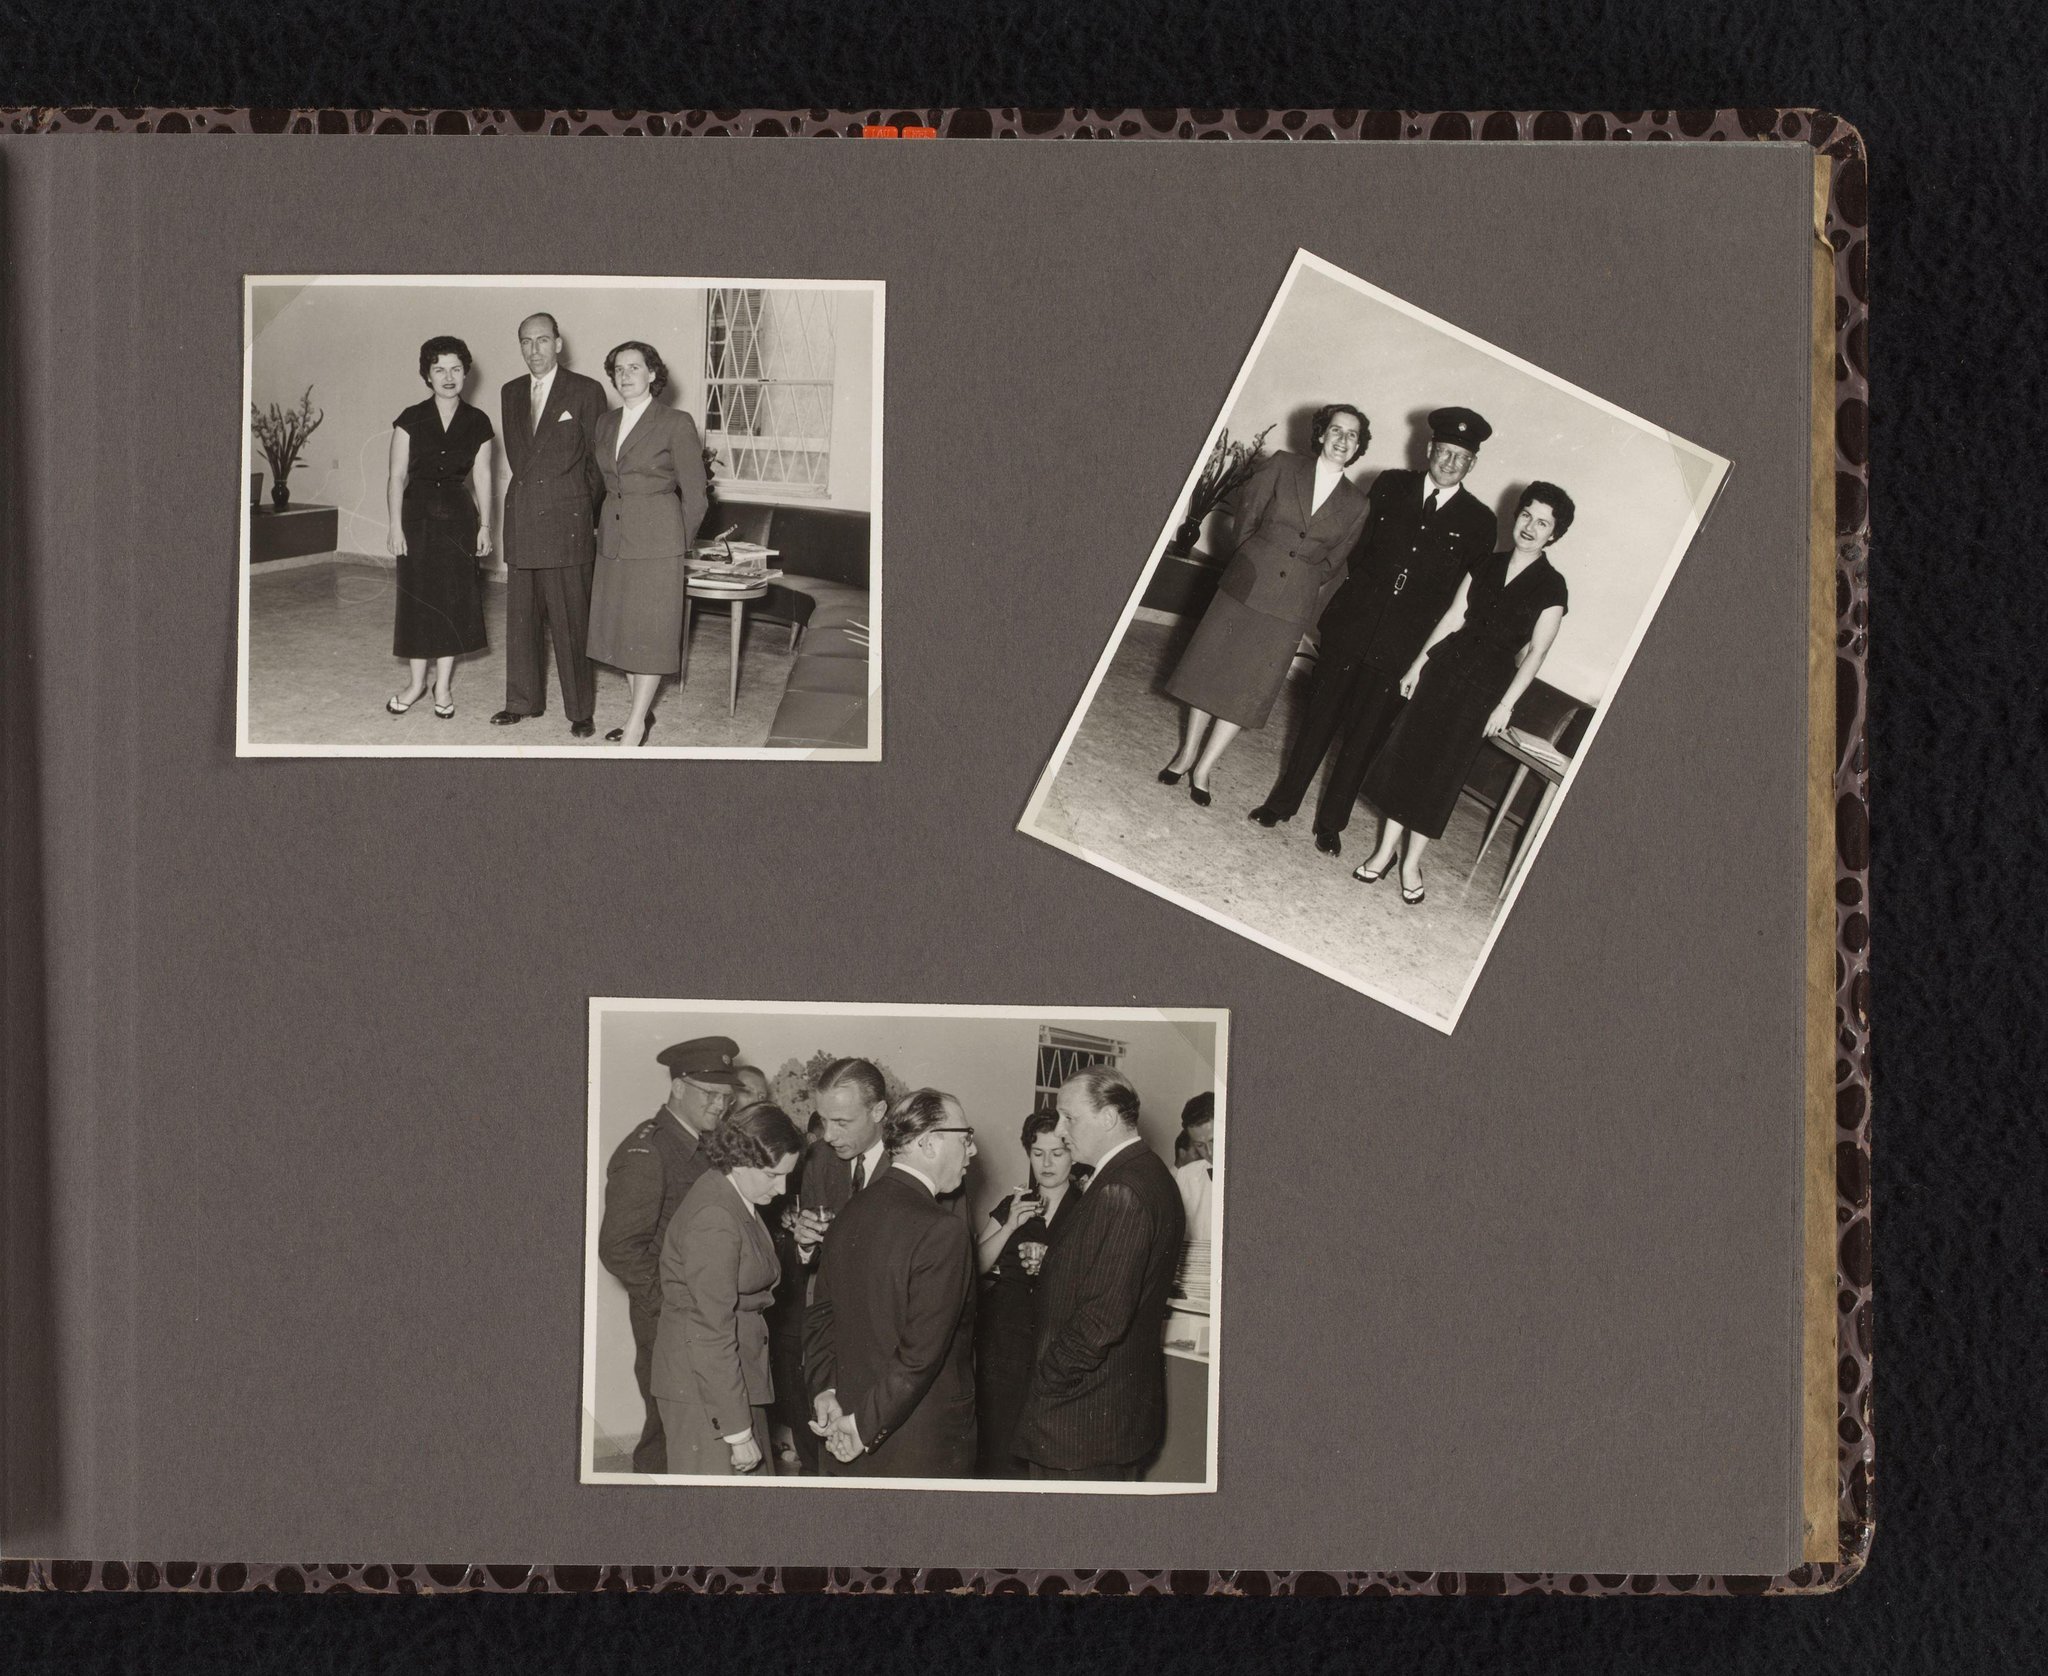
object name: album leaf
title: Isabel Wachenheimer met medewerkers van KLM, 1954, Israël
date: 1904-1954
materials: cardboard, photographic support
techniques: gelatin silver print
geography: tel aviv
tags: isabel wachenheimer-elon, historical persons - bb - woman, anonymous historical persons portrayed in a group, in a group-portrait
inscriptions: copyright notice: ‘Copyright by Photo-Attar (at the yard). 16. Mendele St. Tel-Aviv, Israel.’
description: Blad bevat drie foto's van Isabel Wachenheimer (in KLM-uniform) en onbekende collega's, bij de opening van het nieuwe kantoor, april 1954. Uit album half formaat, kunstlederen omslag met koordbinding.